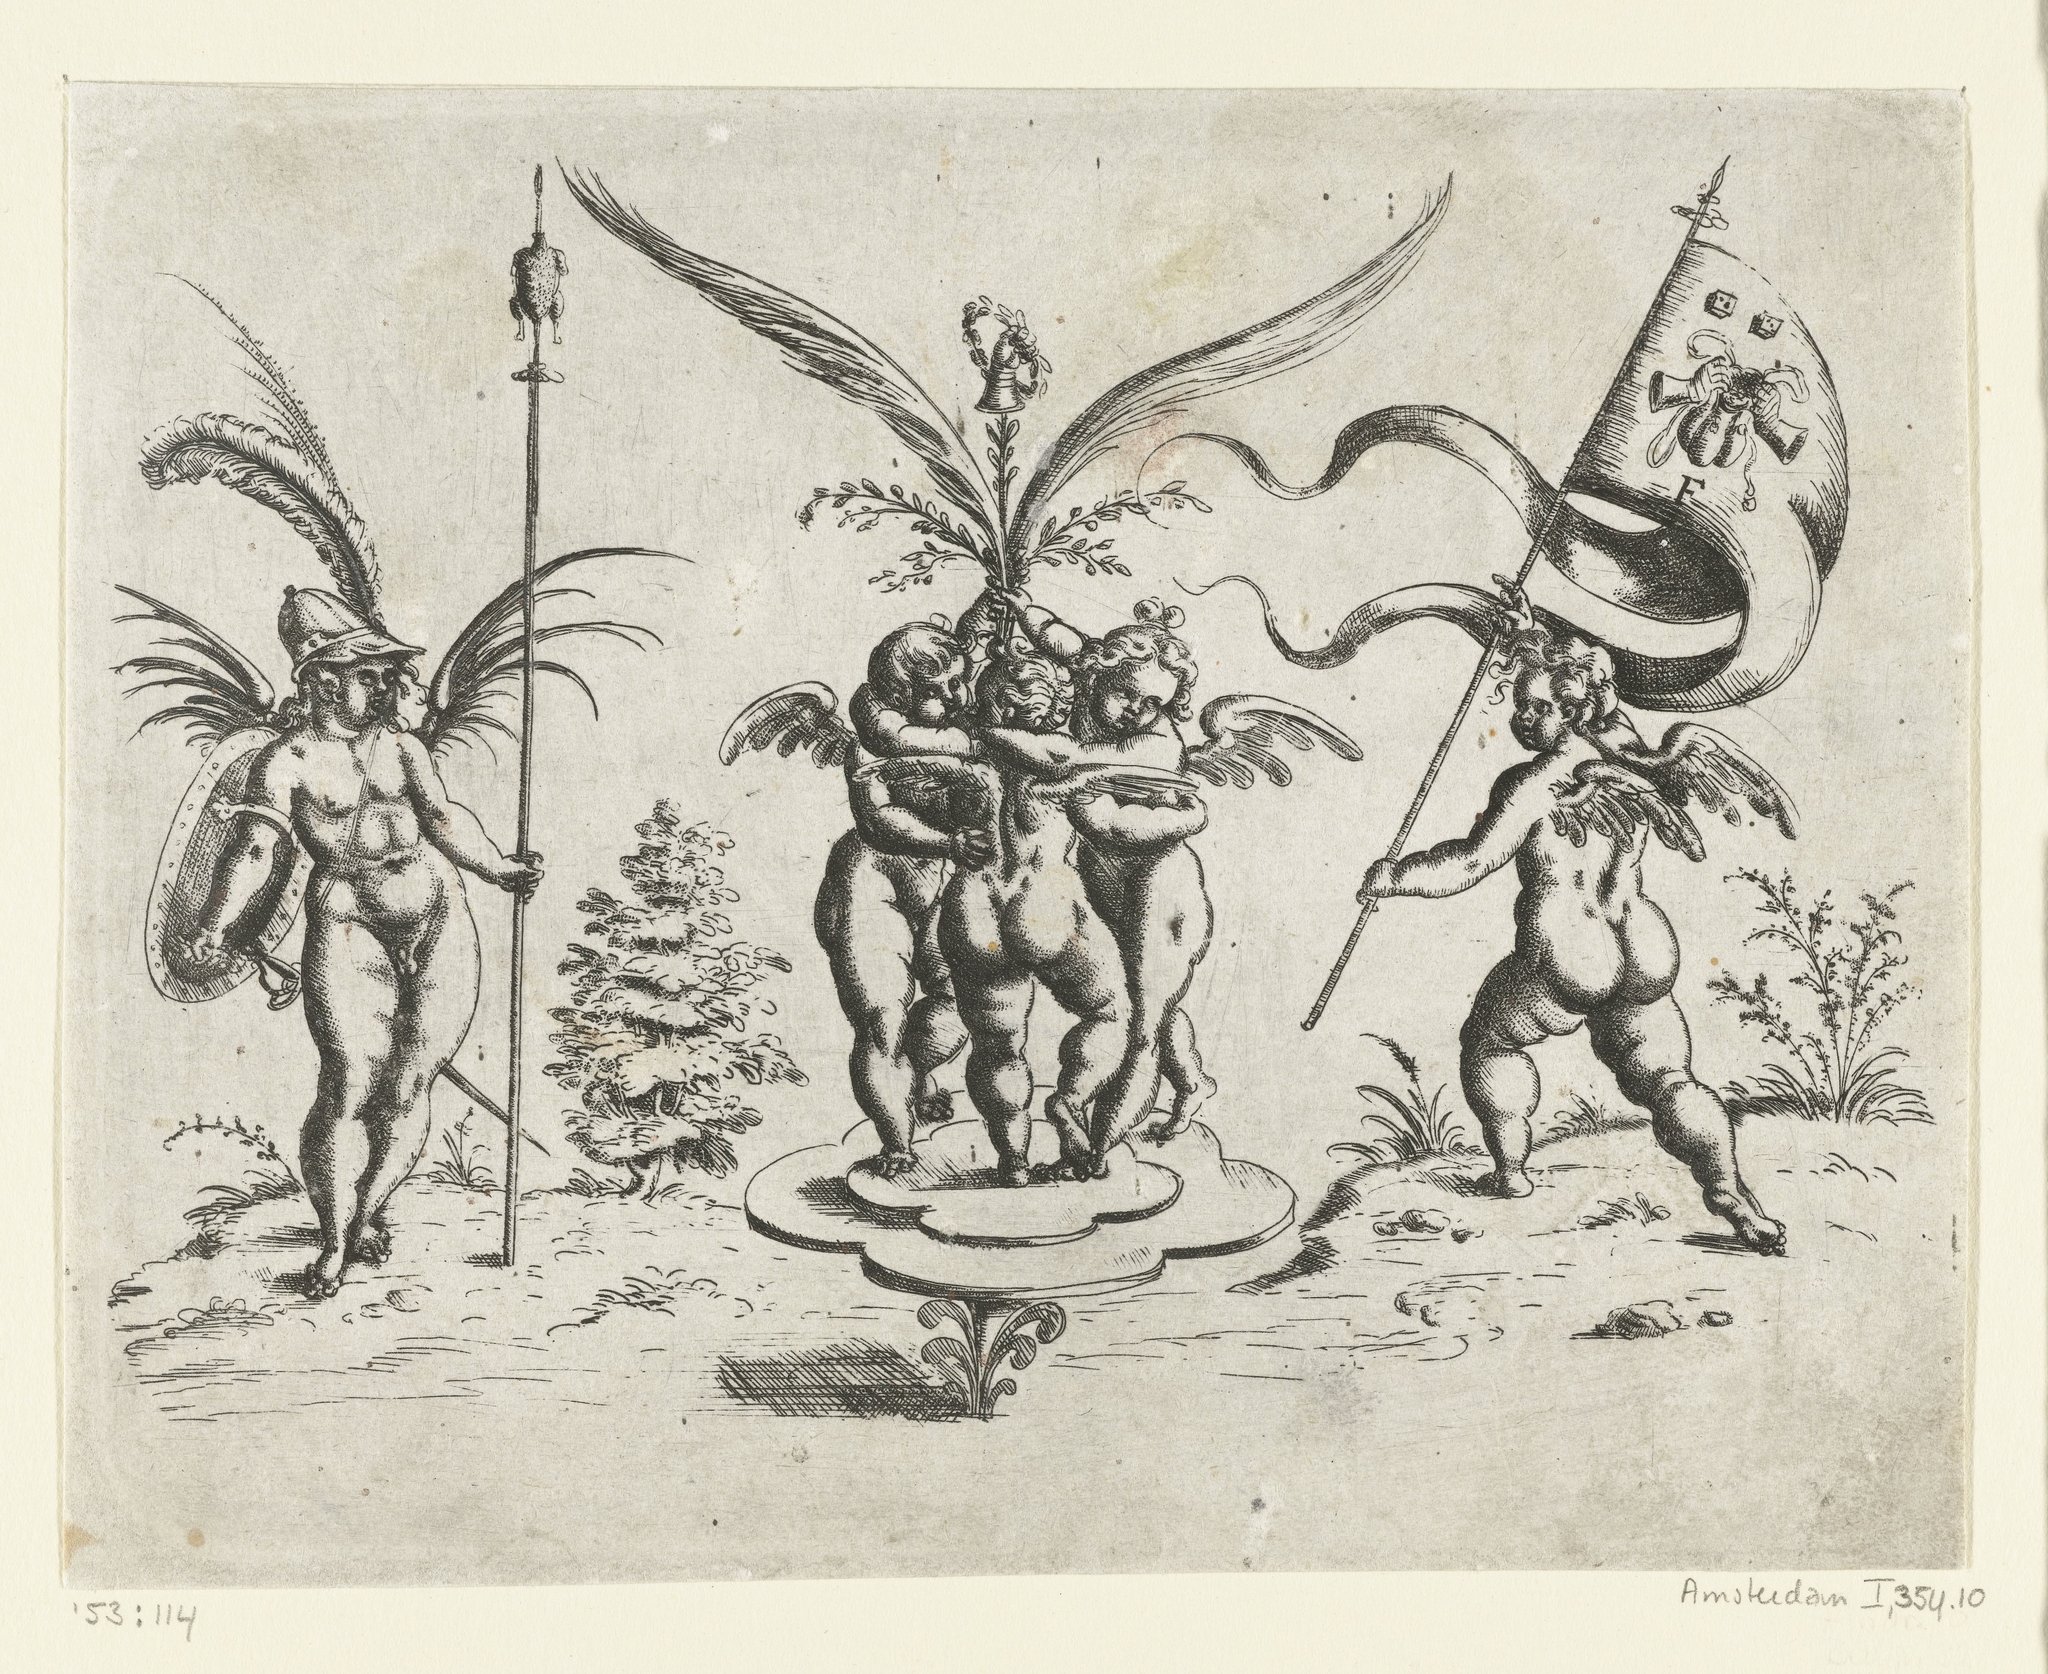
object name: ornament print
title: Das Neuw Grottesken Buch Nürnberg 1610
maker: christoph jamnitzer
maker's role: draughtsman, goldsmith, print maker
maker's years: 1563-1618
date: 1573-1610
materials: paper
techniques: etching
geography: germany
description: Links staat een putto met helm, schild en lans, waarop een braadkip gestoken is. Rechts loopt een putto met een vaandel. Blad uit een serie vlakdecoraties met grotesken, cartouches, ovalen, mascarons, putti en fantastische wezens. De serie bestaat uit drie titelbladen, twee tekstbladen met de opdracht en het voorwoord en 60 bladen, verdeeld over drie boeken.